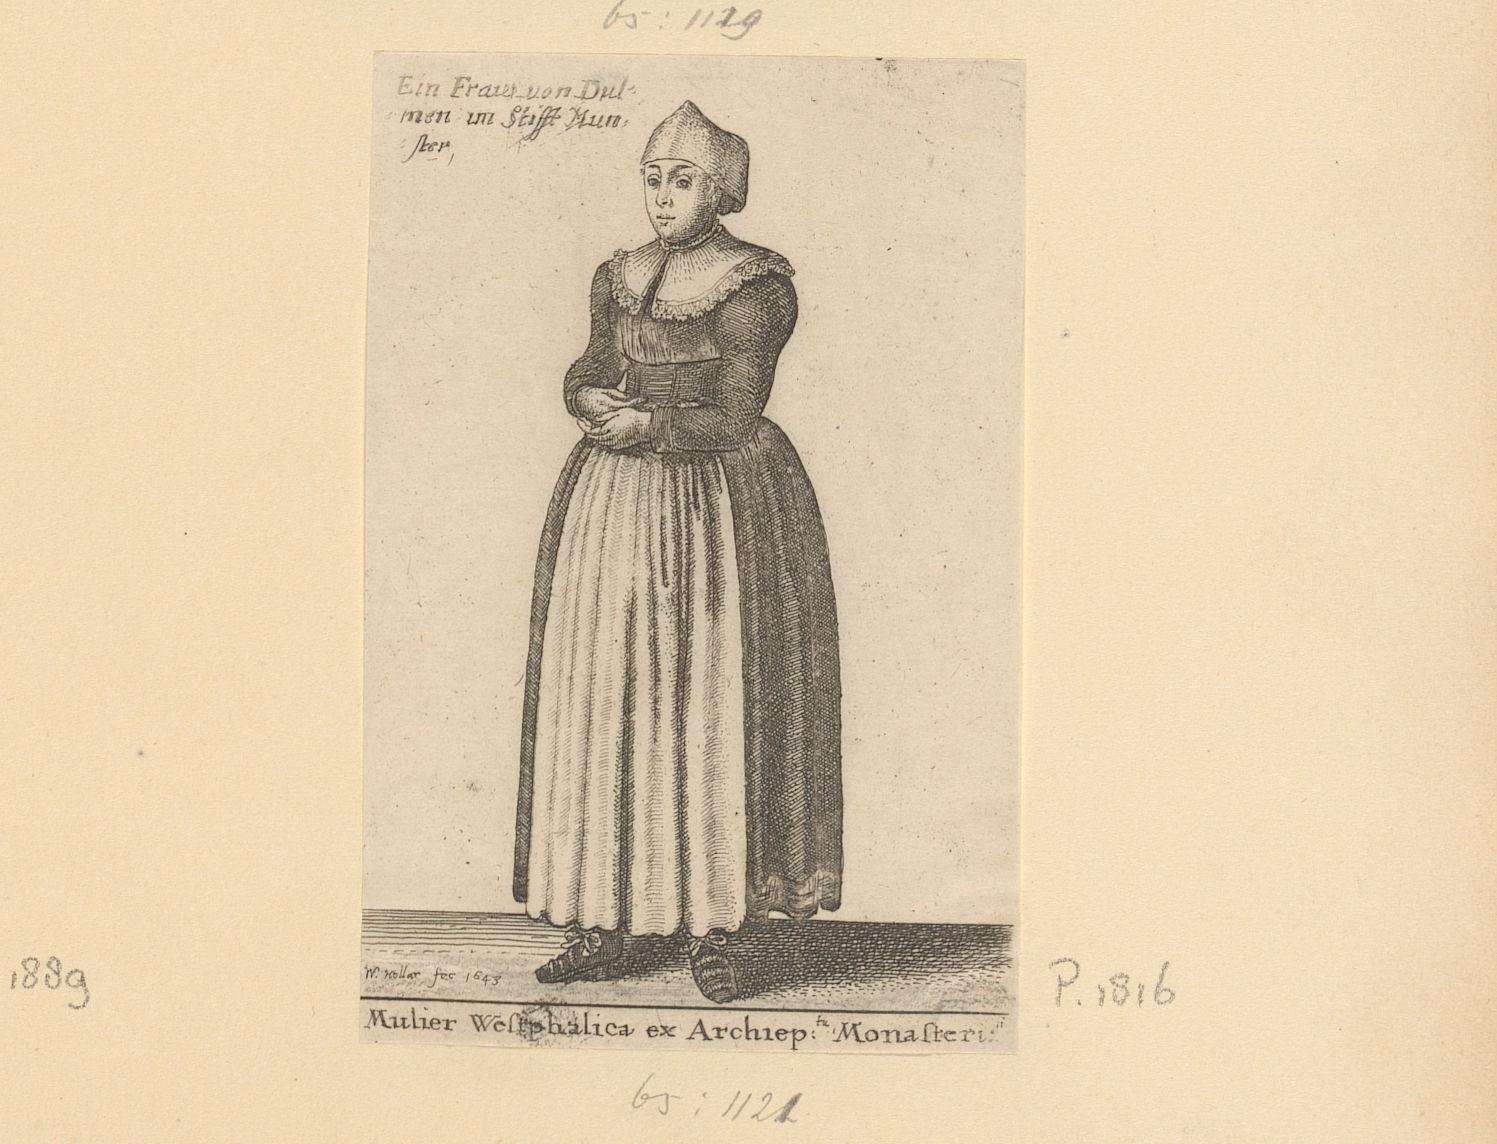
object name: print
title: Vrouw in klederdracht uit Westfalen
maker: wenceslaus hollar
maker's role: draughtsman, print maker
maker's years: 1607-1677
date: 1643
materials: paper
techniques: etching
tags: adult woman, folk costume, regional costume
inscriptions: date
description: Prent maakt mogelijk deel uit van een serie van 200 prenten. Deze serie is onder de titel 'A Collection of two hundred original etchings' voor het eerst uitgegeven door J.M. Greery in 1816.